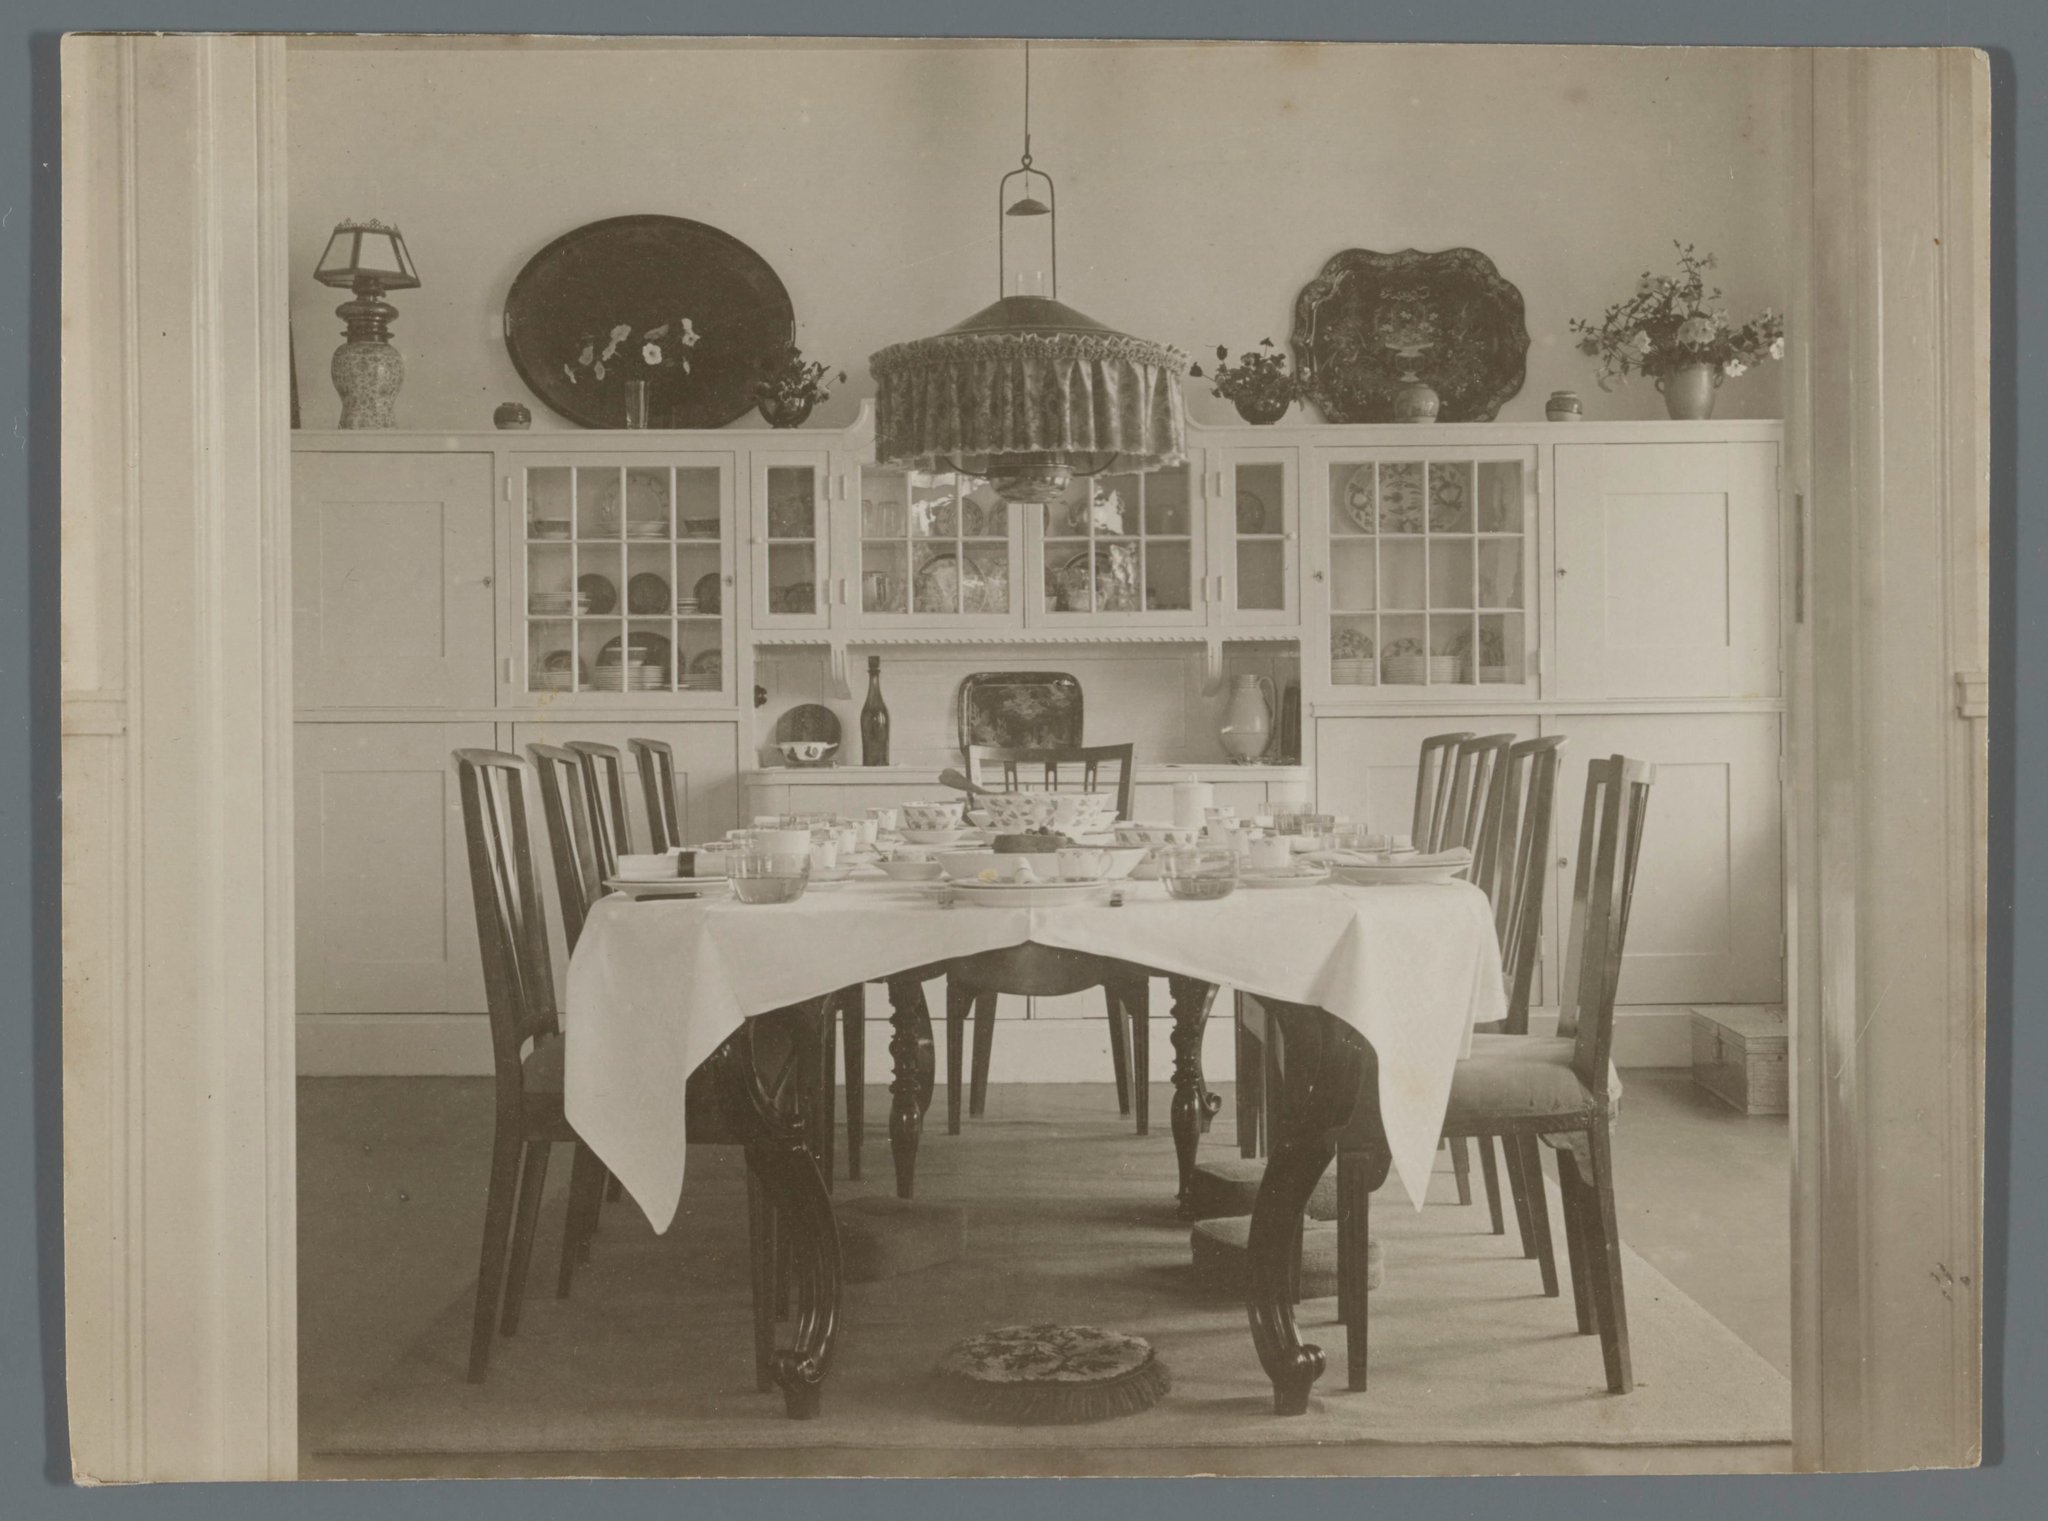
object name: photograph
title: Eetkamer met gedekte tafel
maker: cornelia hendrika jonker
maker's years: 1874-1924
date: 1880-1940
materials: photographic support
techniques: gelatin silver print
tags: interior of the house, dining-room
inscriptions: annotation: ‘'t Velthuys’